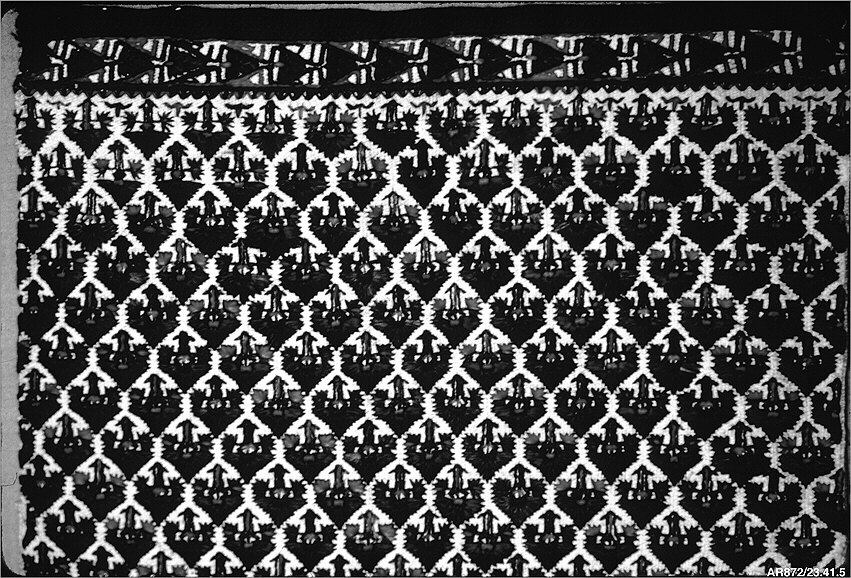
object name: cuff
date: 1801-1900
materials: cotton, silk